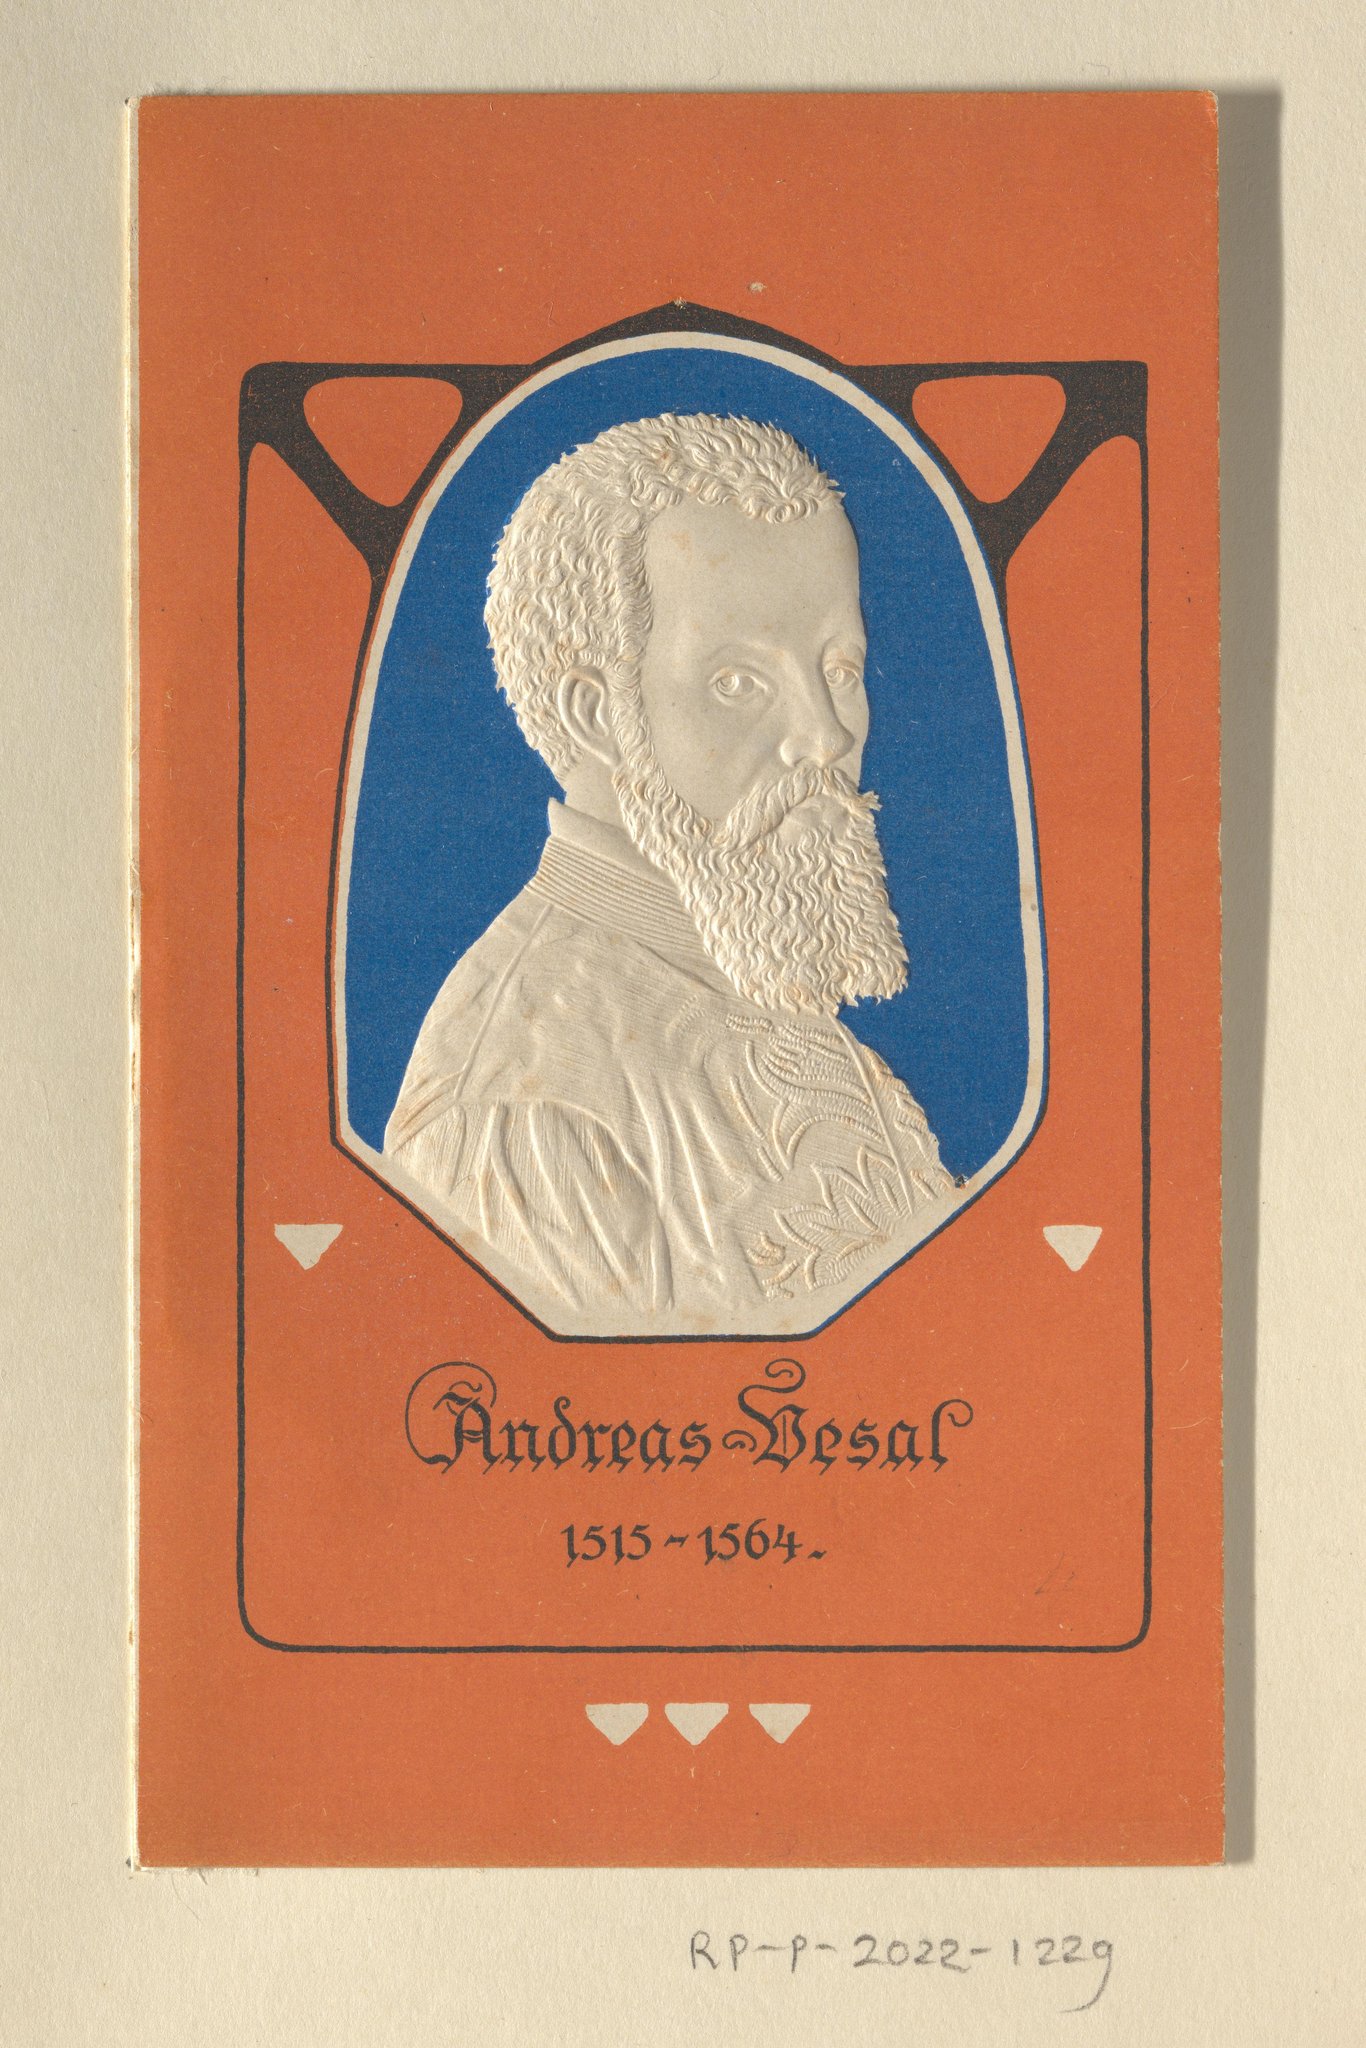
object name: print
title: Galerie berühmter Ärzte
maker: Anonymous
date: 1910-1915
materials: paper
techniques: blind stamped, lithograph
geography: germany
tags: advertising, physician, doctor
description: Kaart met portretbuste van de arts Andreas Vesalius. Onderdeel van de serie kaarten in reliëfdruk uitgebracht als reclame voor de medische producten van Tropon-Werke, Mülheim am Rhein.